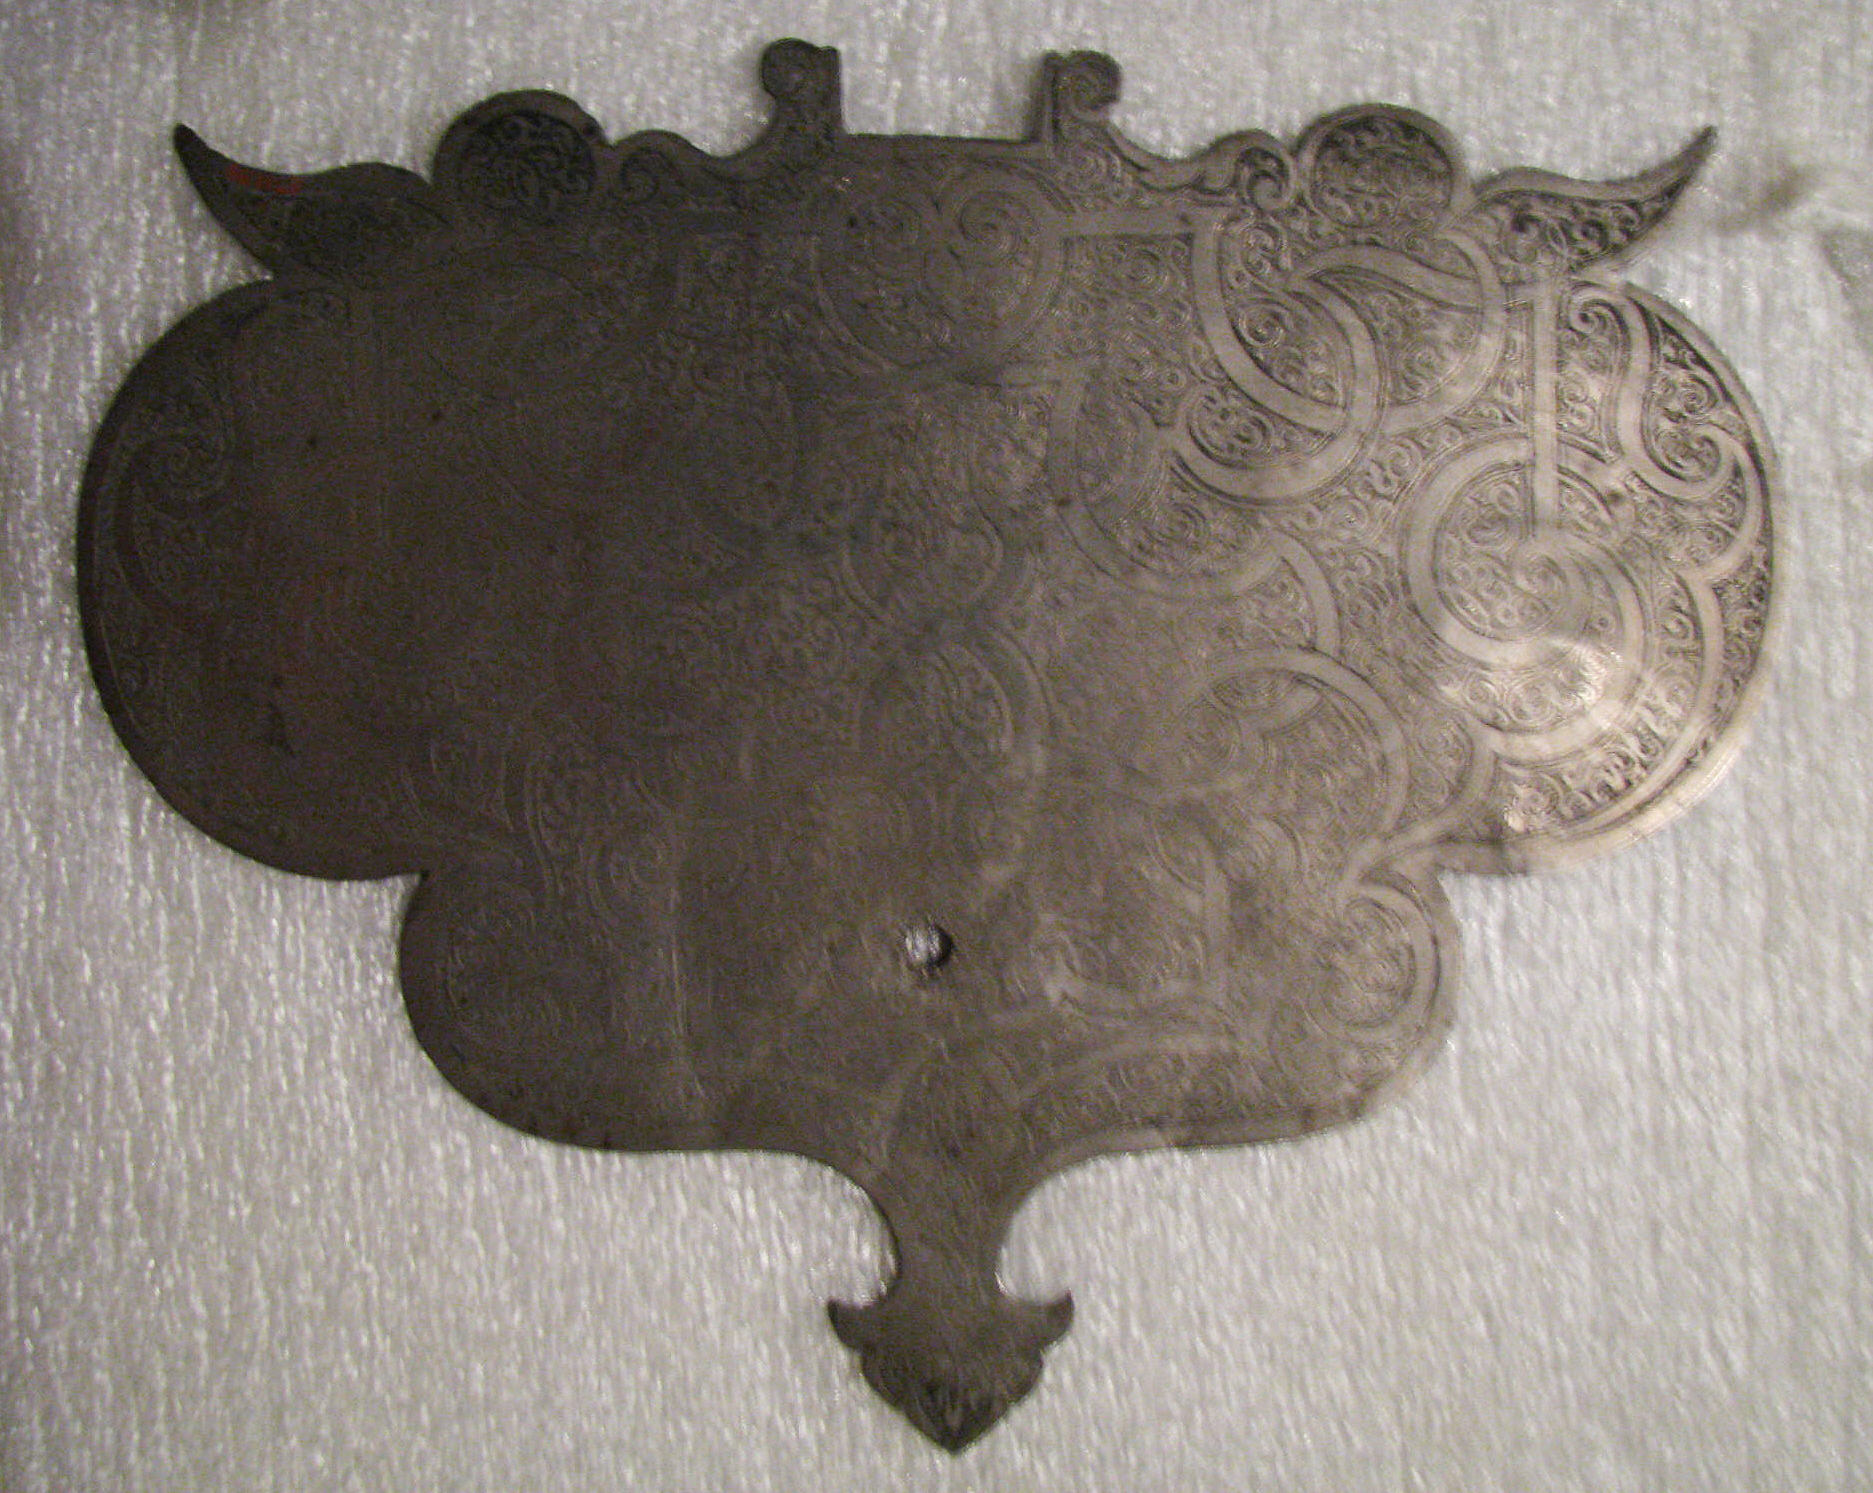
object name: inside lock plate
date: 1600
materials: iron